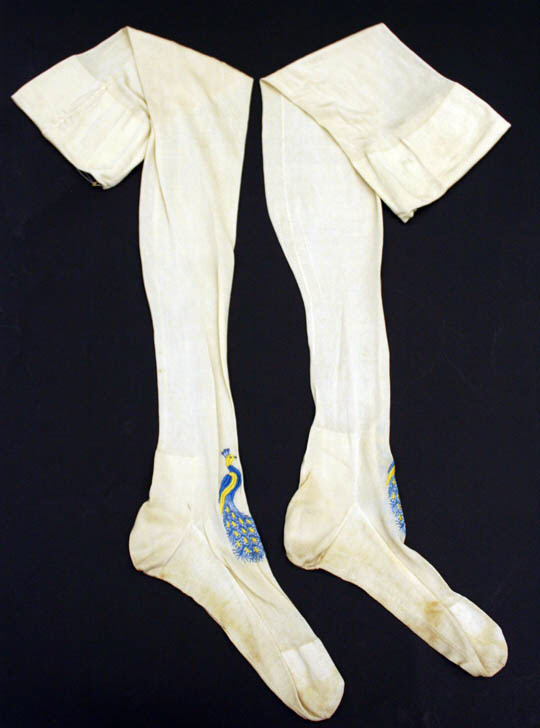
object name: stocking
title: Stockings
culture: french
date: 1875-1899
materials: cotton, silk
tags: peacocks